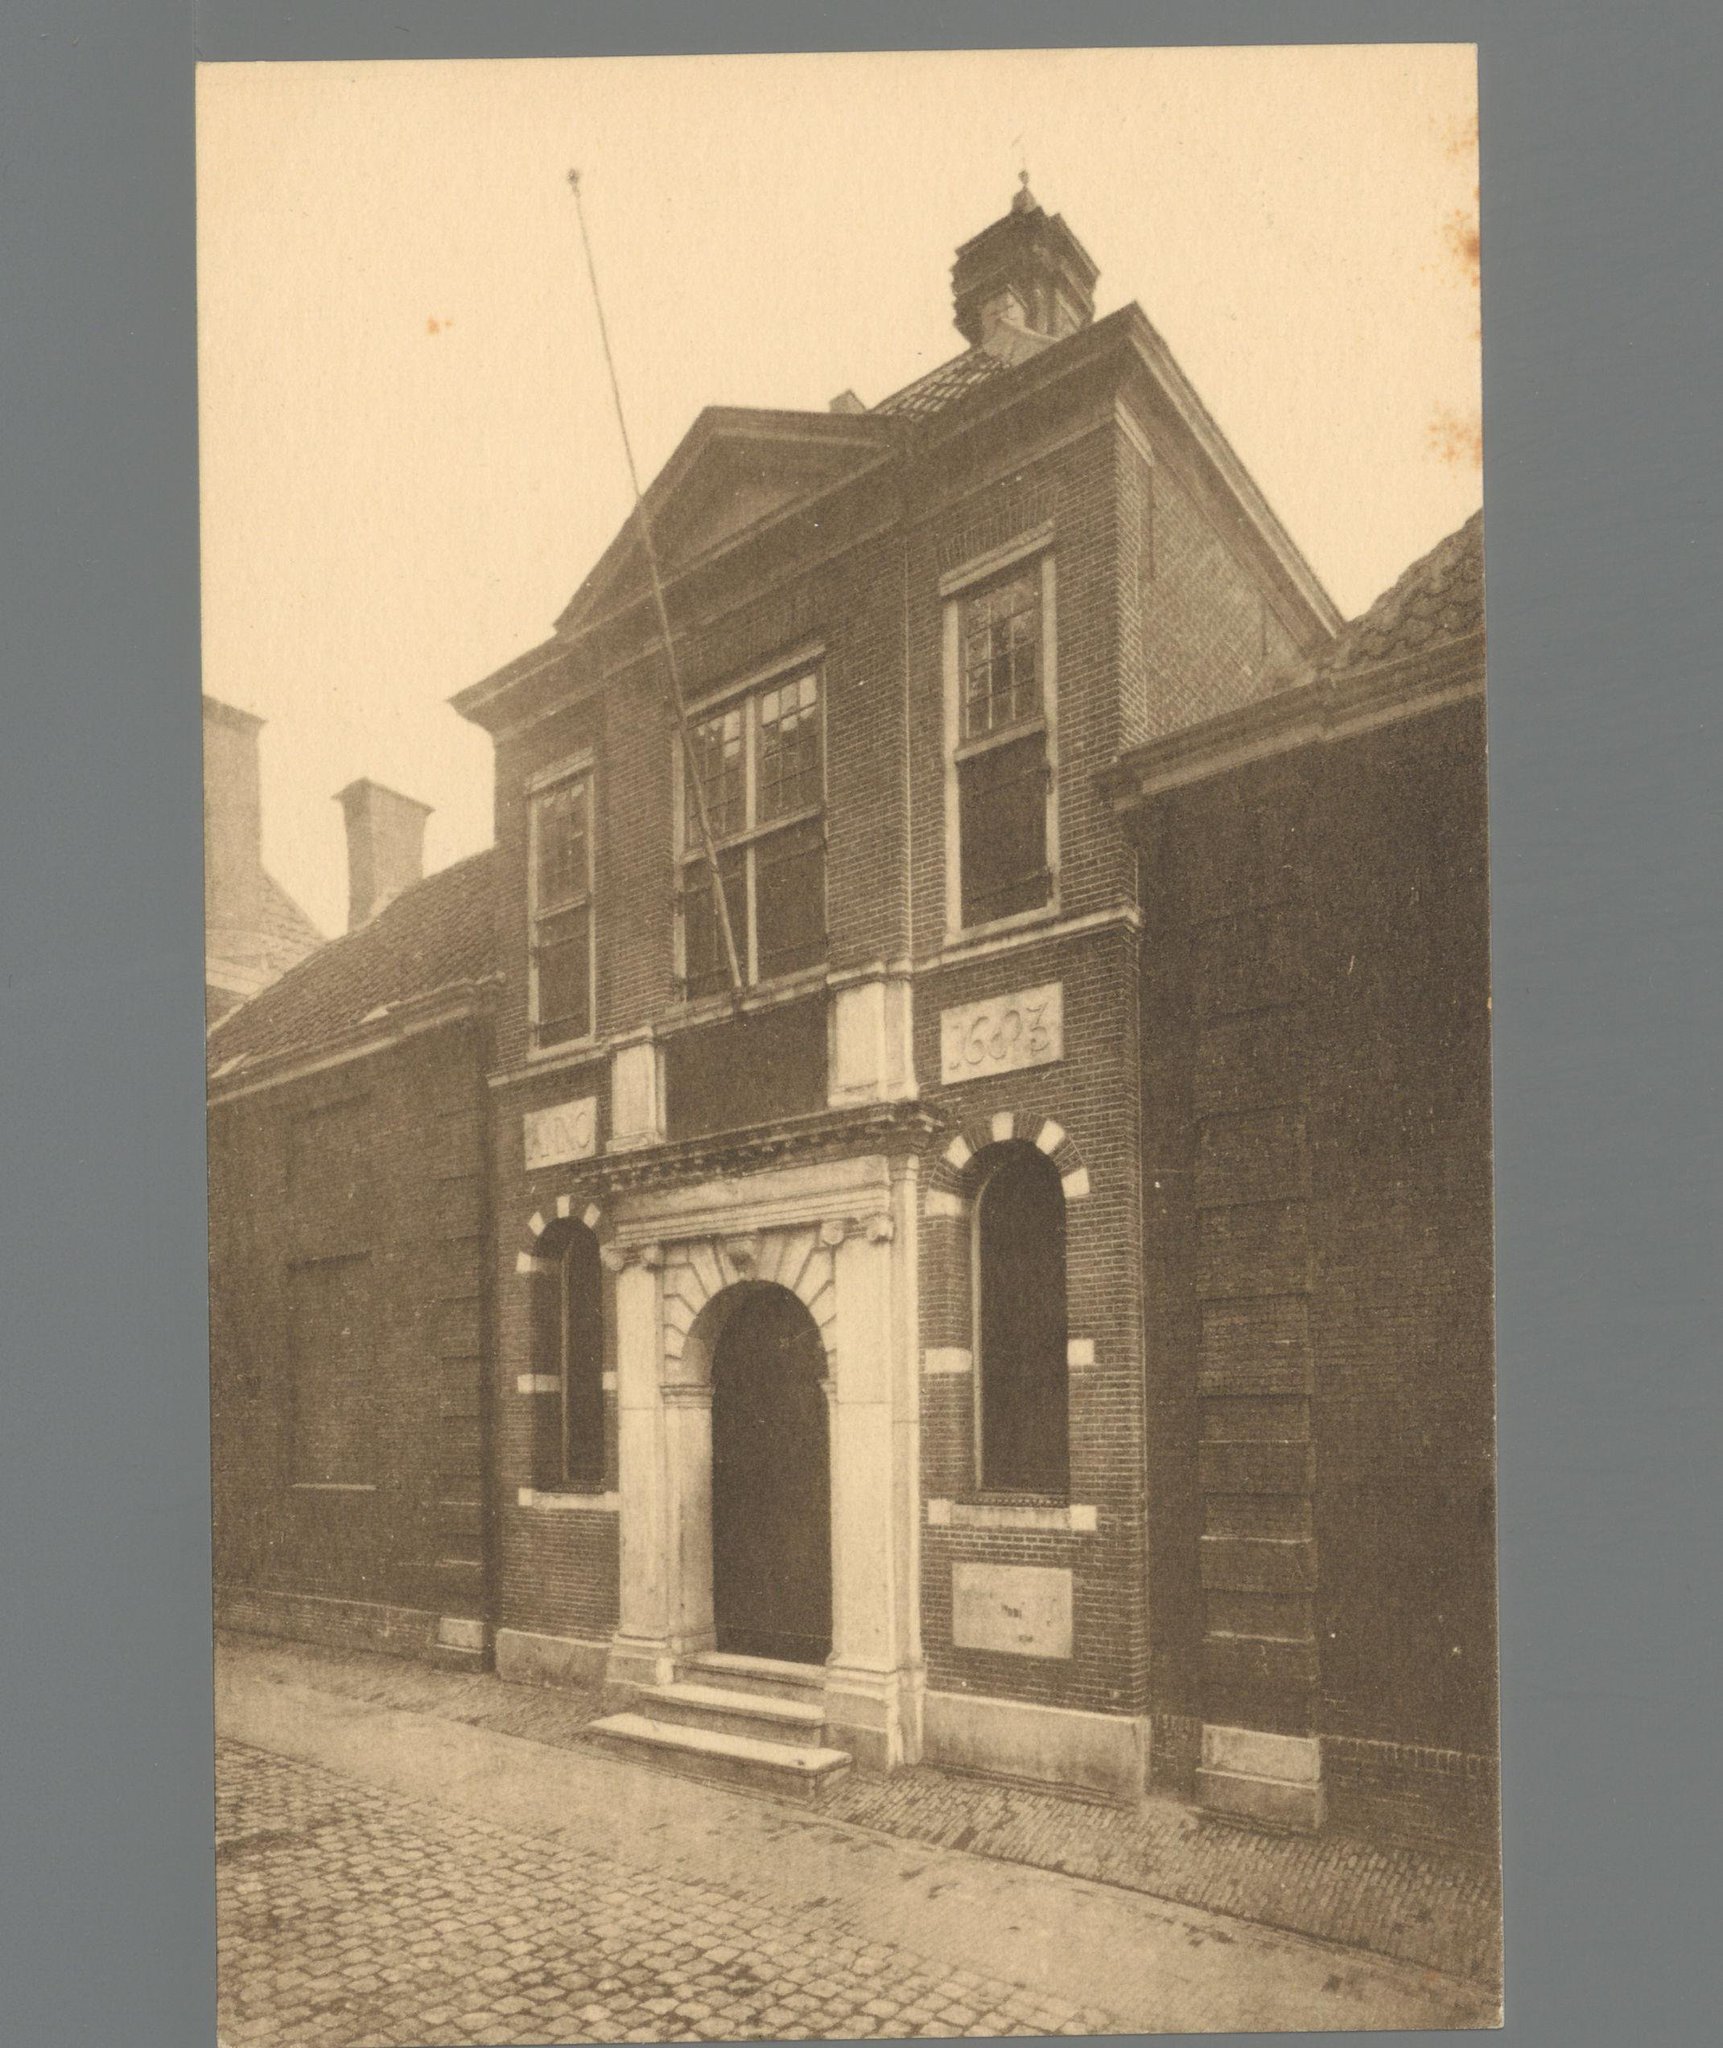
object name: ansichtkaart, prentbriefkaart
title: Leiden. Jan Pesijnshof, Kloksteeg No 21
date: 1905-1930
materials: cardboard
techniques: photograph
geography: leiden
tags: alms-house (dutch: 'hofje'), gate, entrance